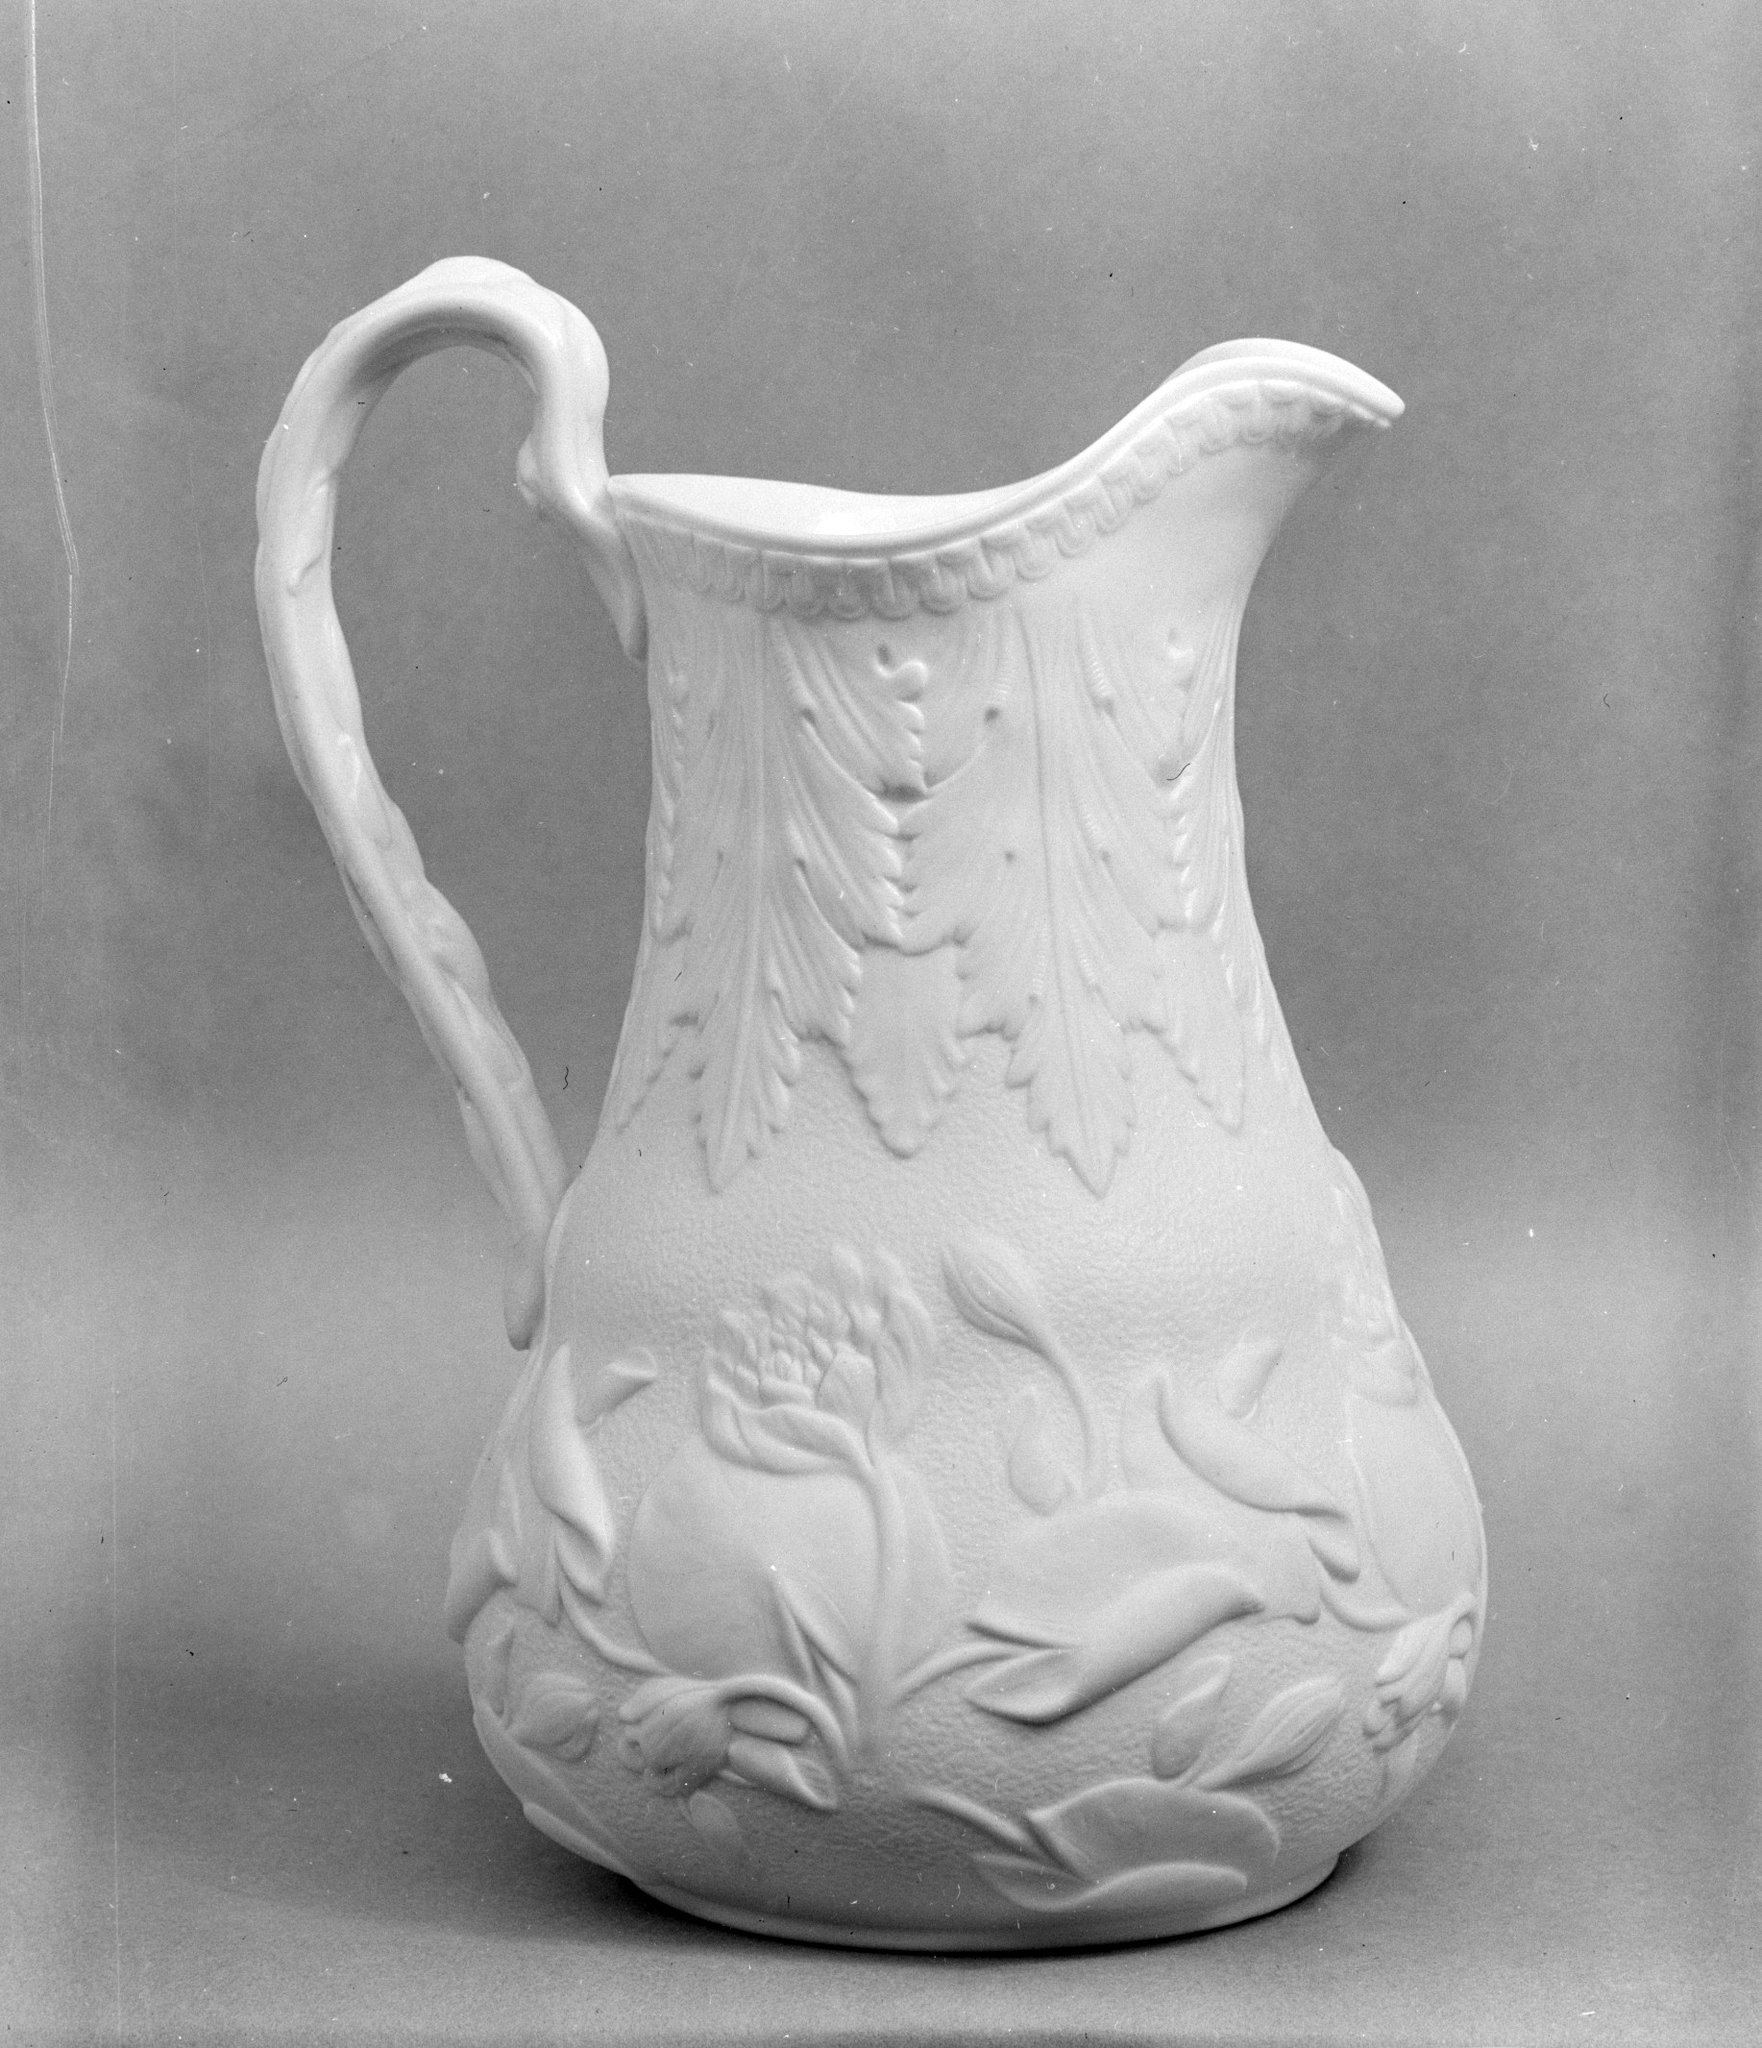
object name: pitcher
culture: american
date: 1830-1870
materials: porcelain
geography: united states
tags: flowers